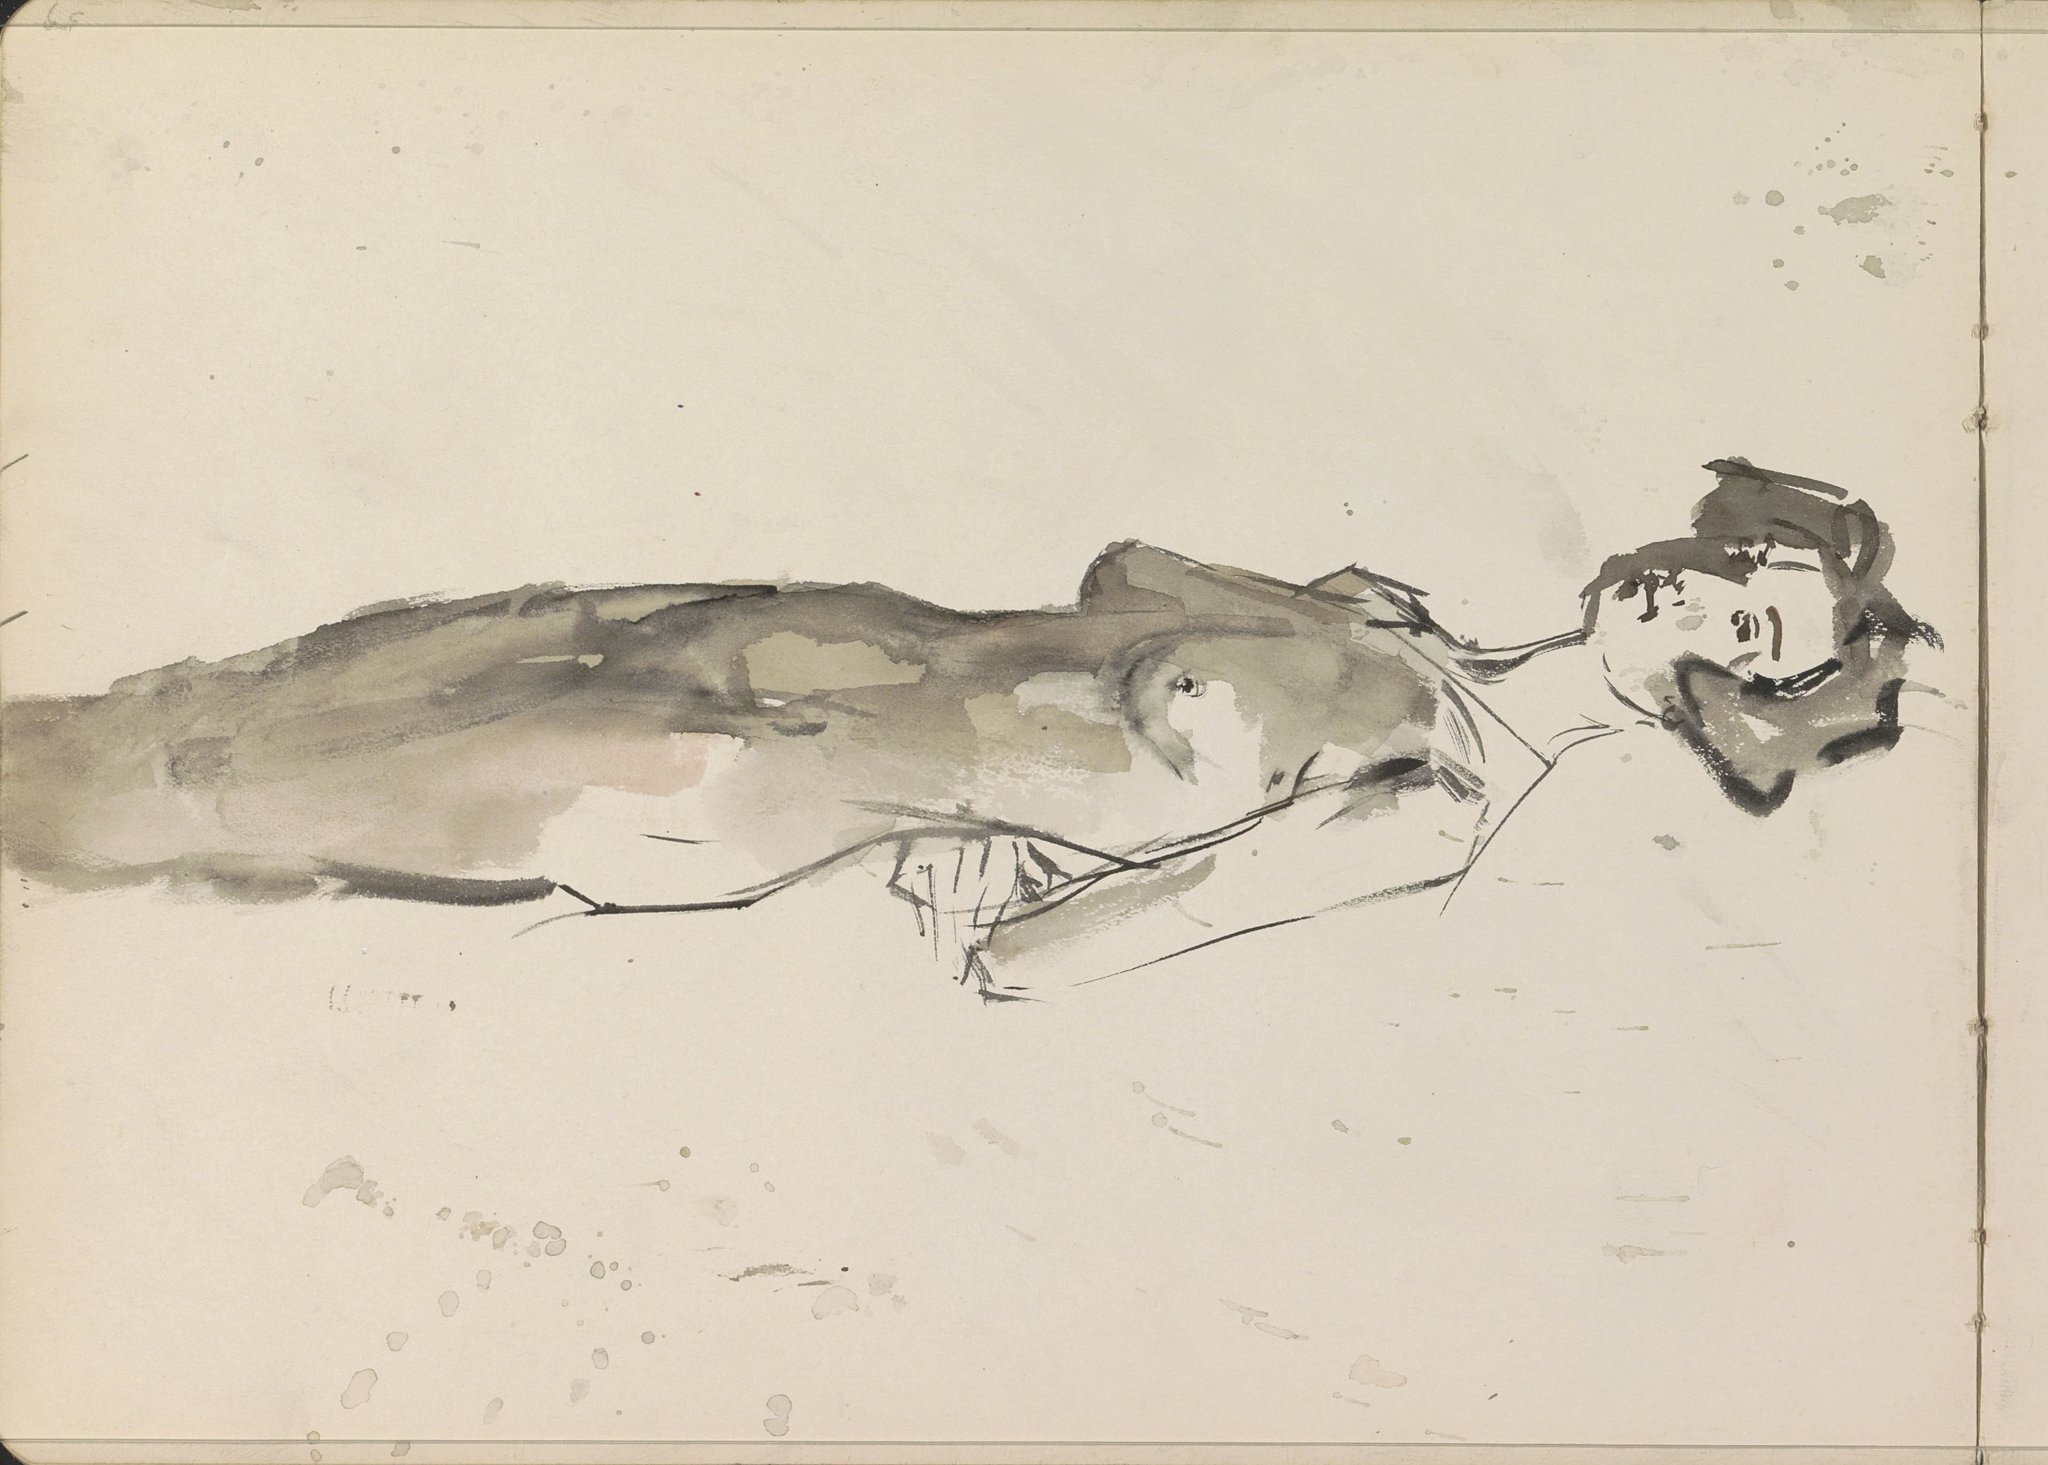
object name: sketchbook leaf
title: Standing Female Nude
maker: isaac israels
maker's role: draughtsman, painter, print maker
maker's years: 1865-1934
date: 1915-1934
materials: paper, watercolor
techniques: brush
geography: the hague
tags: standing figure - aa - female human figure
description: Blad 8 verso uit schetsboek VI met 33 bladen.